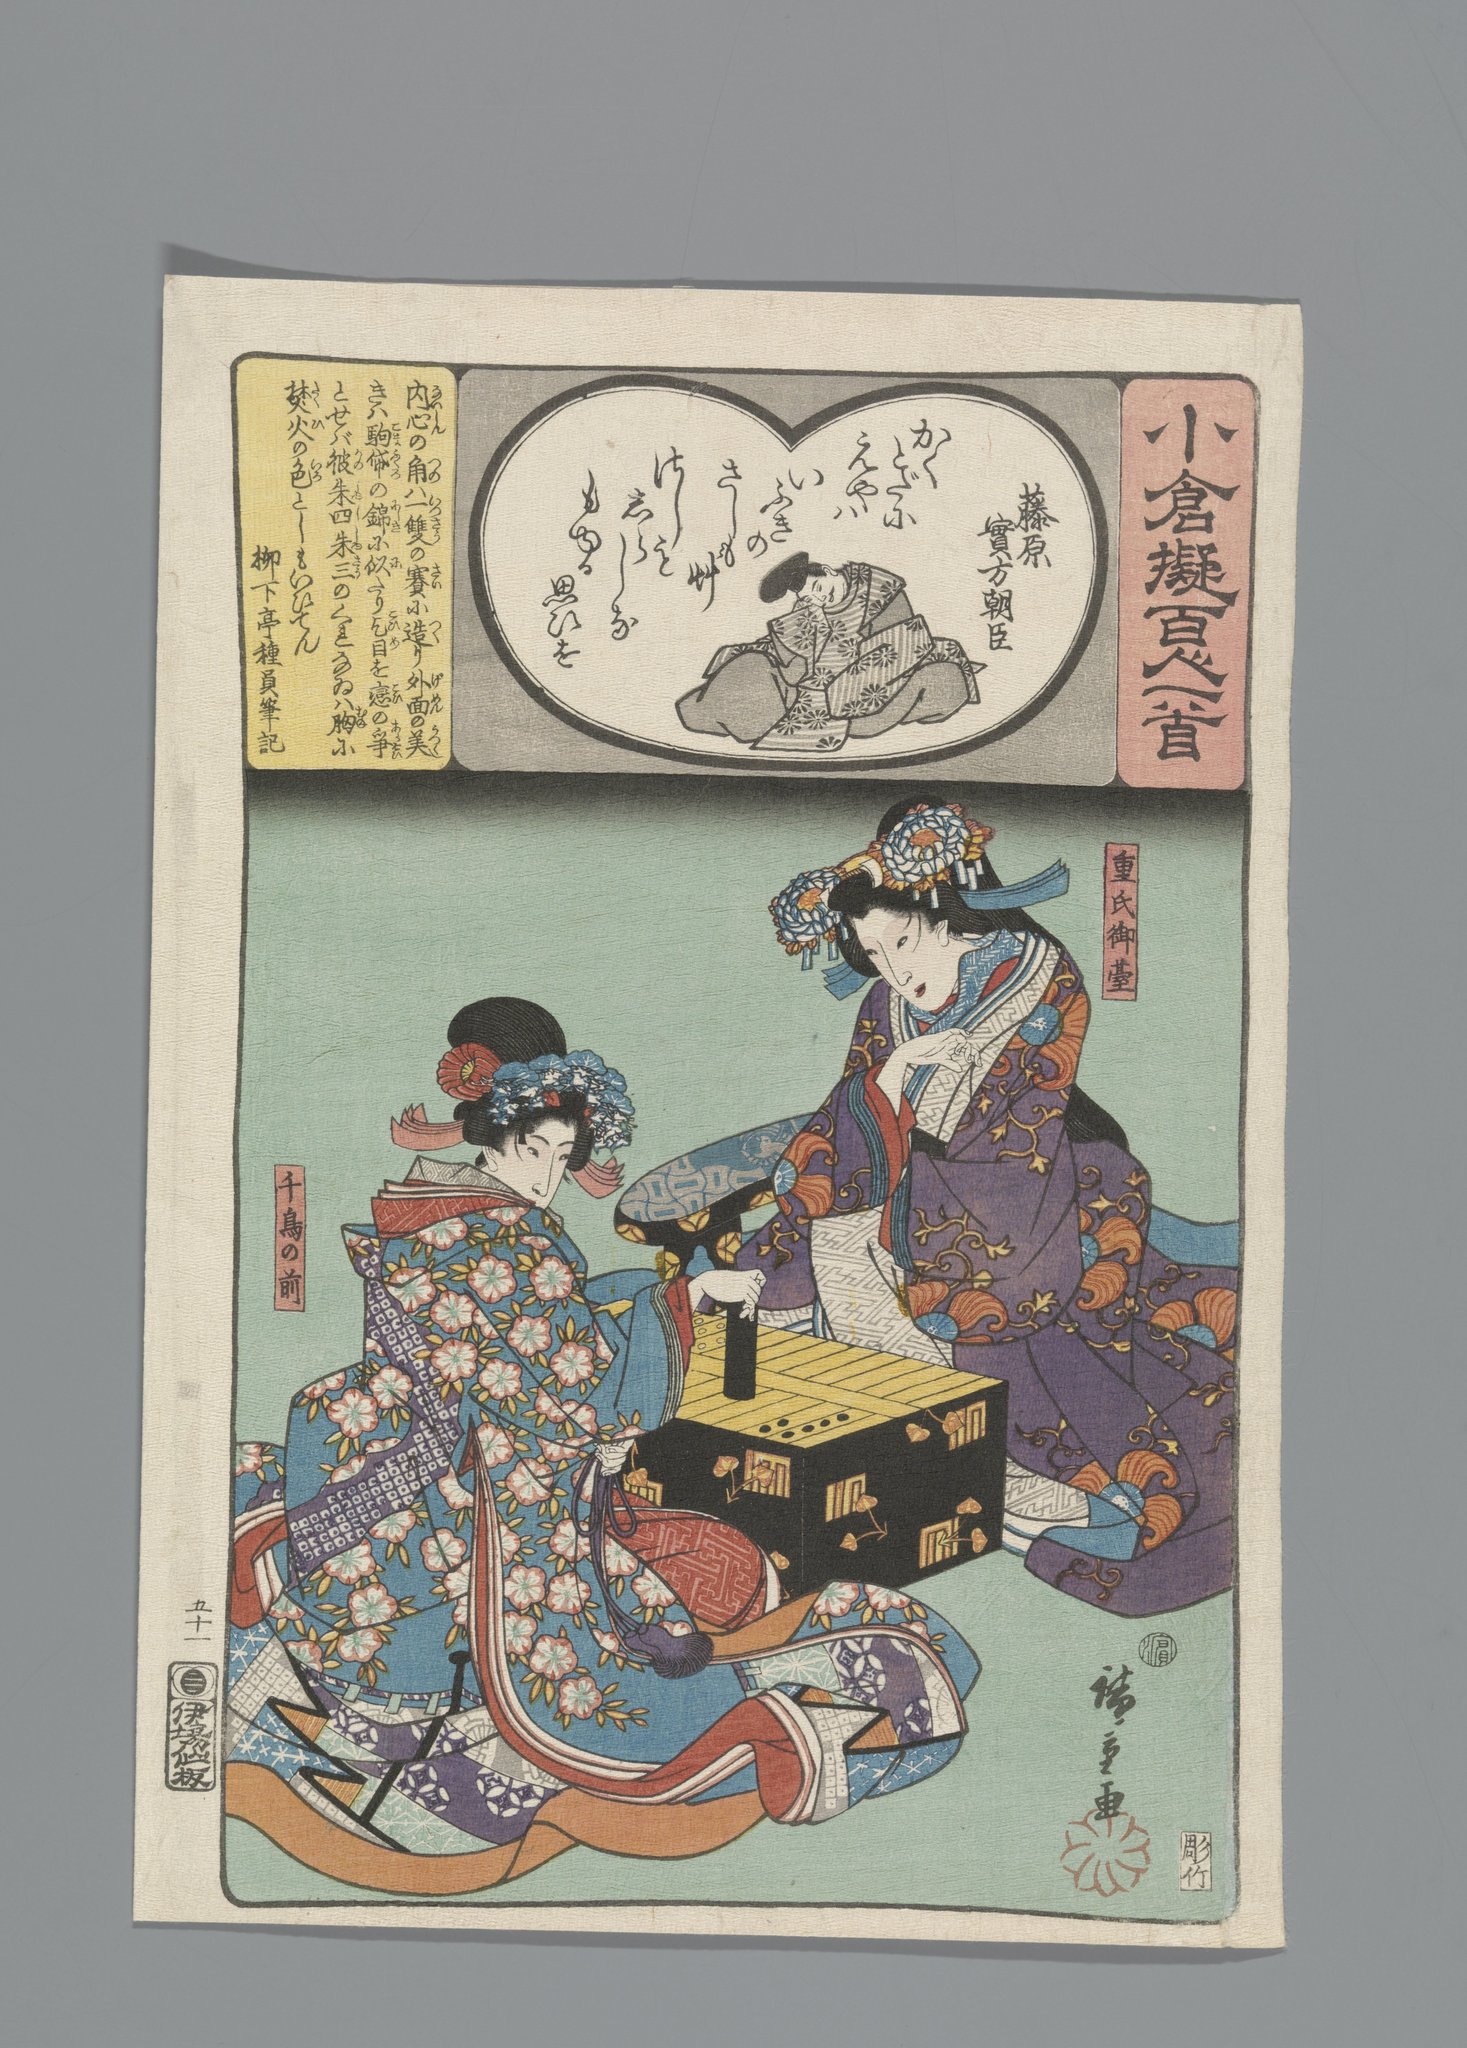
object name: print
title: Ogura Imitation of the One Hundred Poems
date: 1843-1846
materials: paper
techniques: woodcut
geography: japan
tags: concubine, backgammon, tric-trac, adult woman (+ two persons)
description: Midai en Chidori spelen backgammon. Midai is de eerste vrouw van Shigeuji, Chidori zijn concubine. De status van de eerste vrouw is onder andere af te lezen aan haar stoel, waar een armleuning aan zit. Het gedicht door Fujiwara no Sanekata Ason verwijst naar de diepe jaloezie die de vrouwen voor elkaar voelen. Scene uit een kabukitoneelstuk.